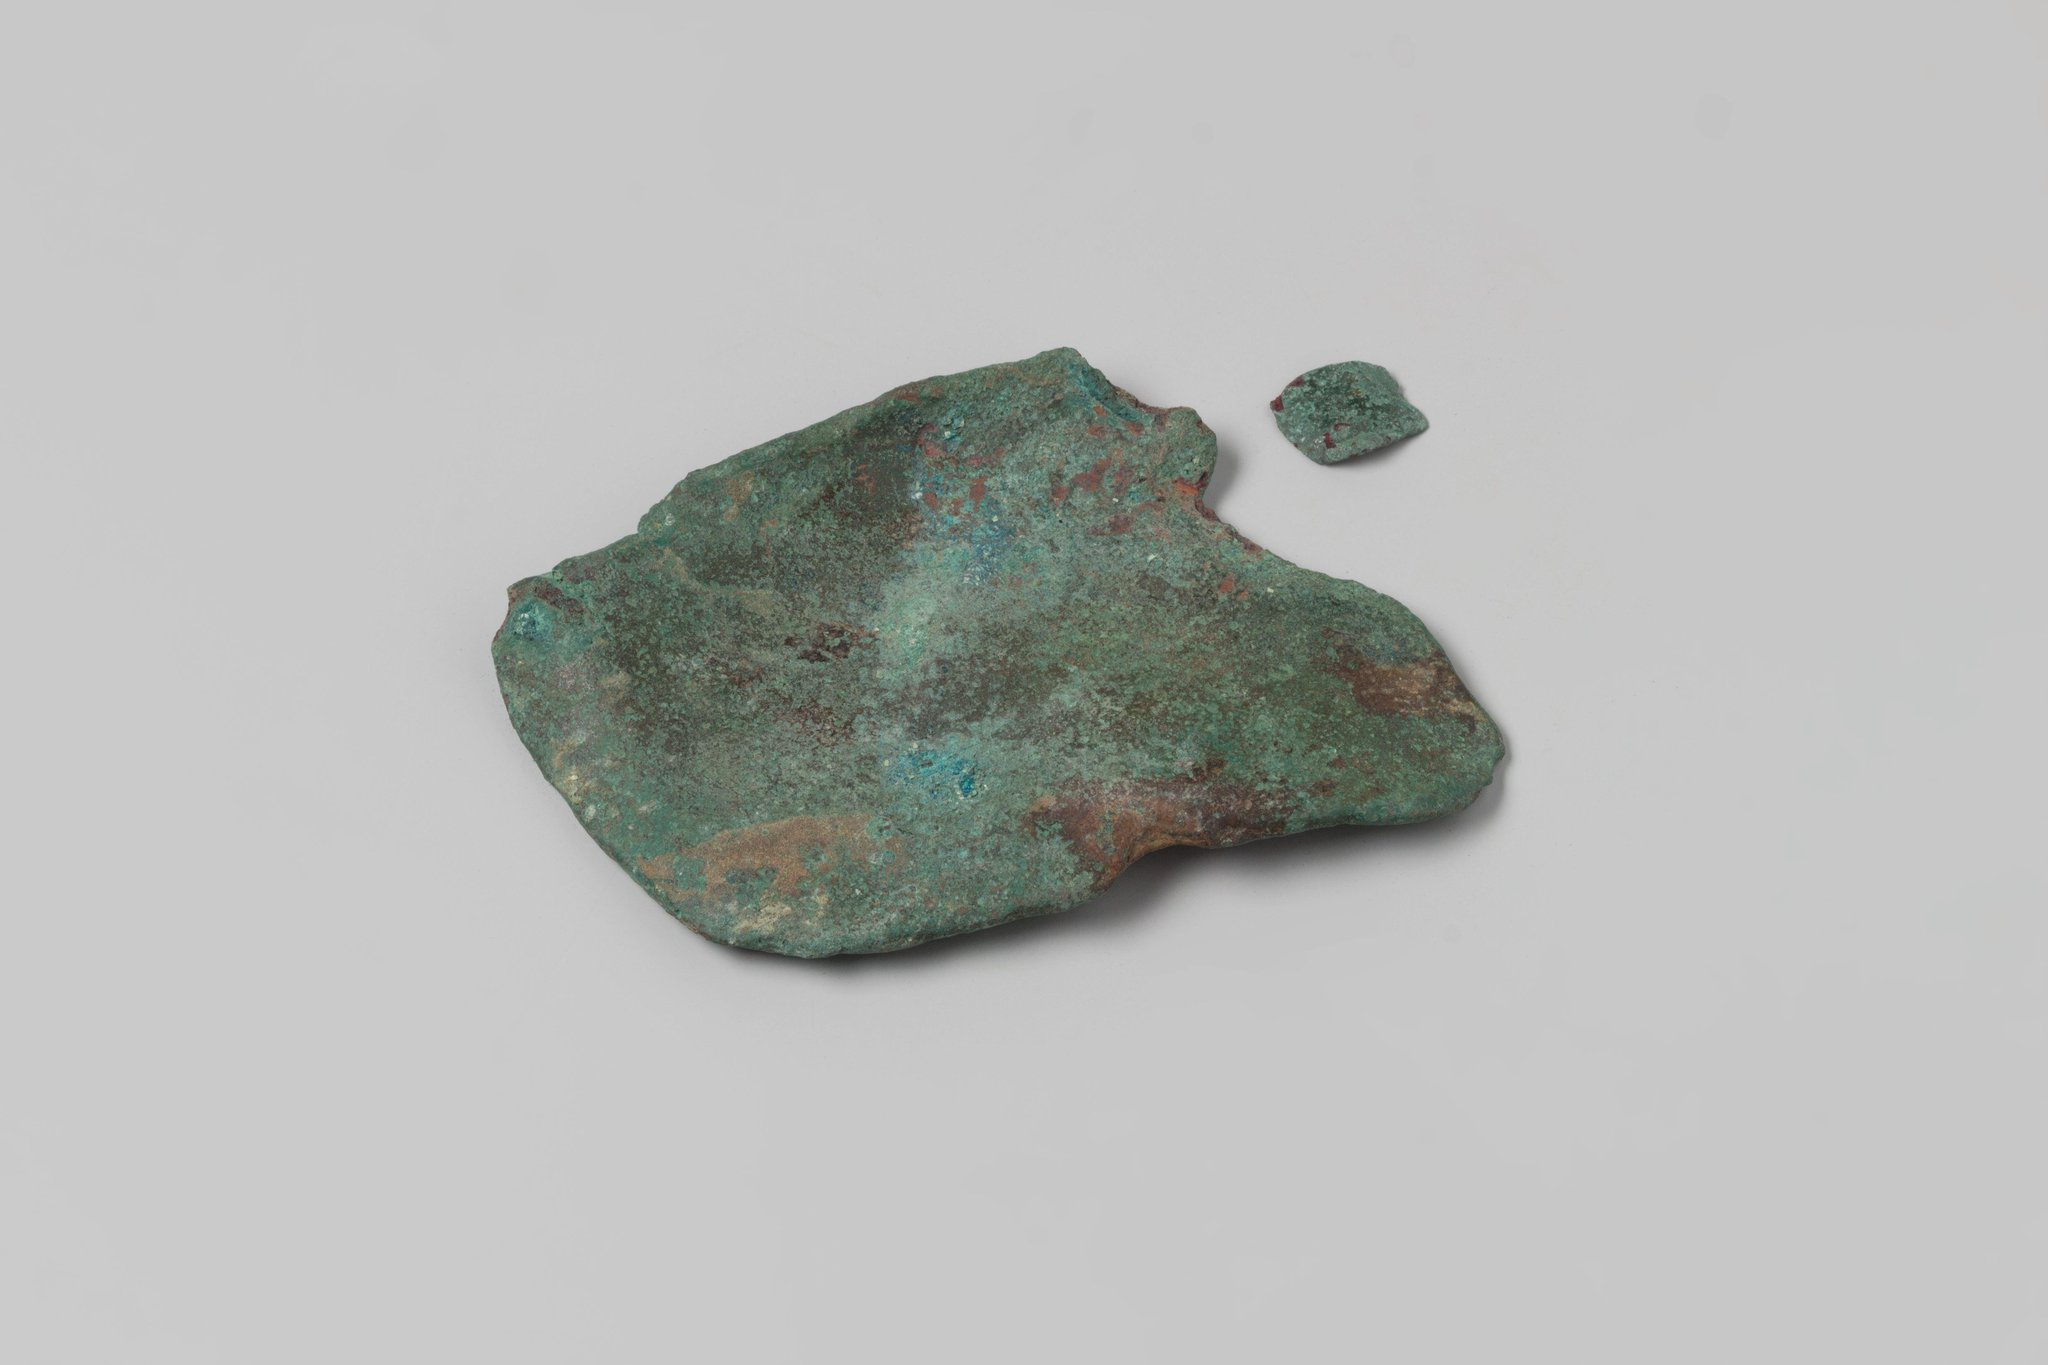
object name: fragment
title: Fragmenten plaatwerk uit het wrak van de Oost-Indiëvaarder Hollandia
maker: Anonymous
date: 1700-1743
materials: copper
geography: netherlands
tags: verenigde oostindische compagnie, hollandia (schip), annet